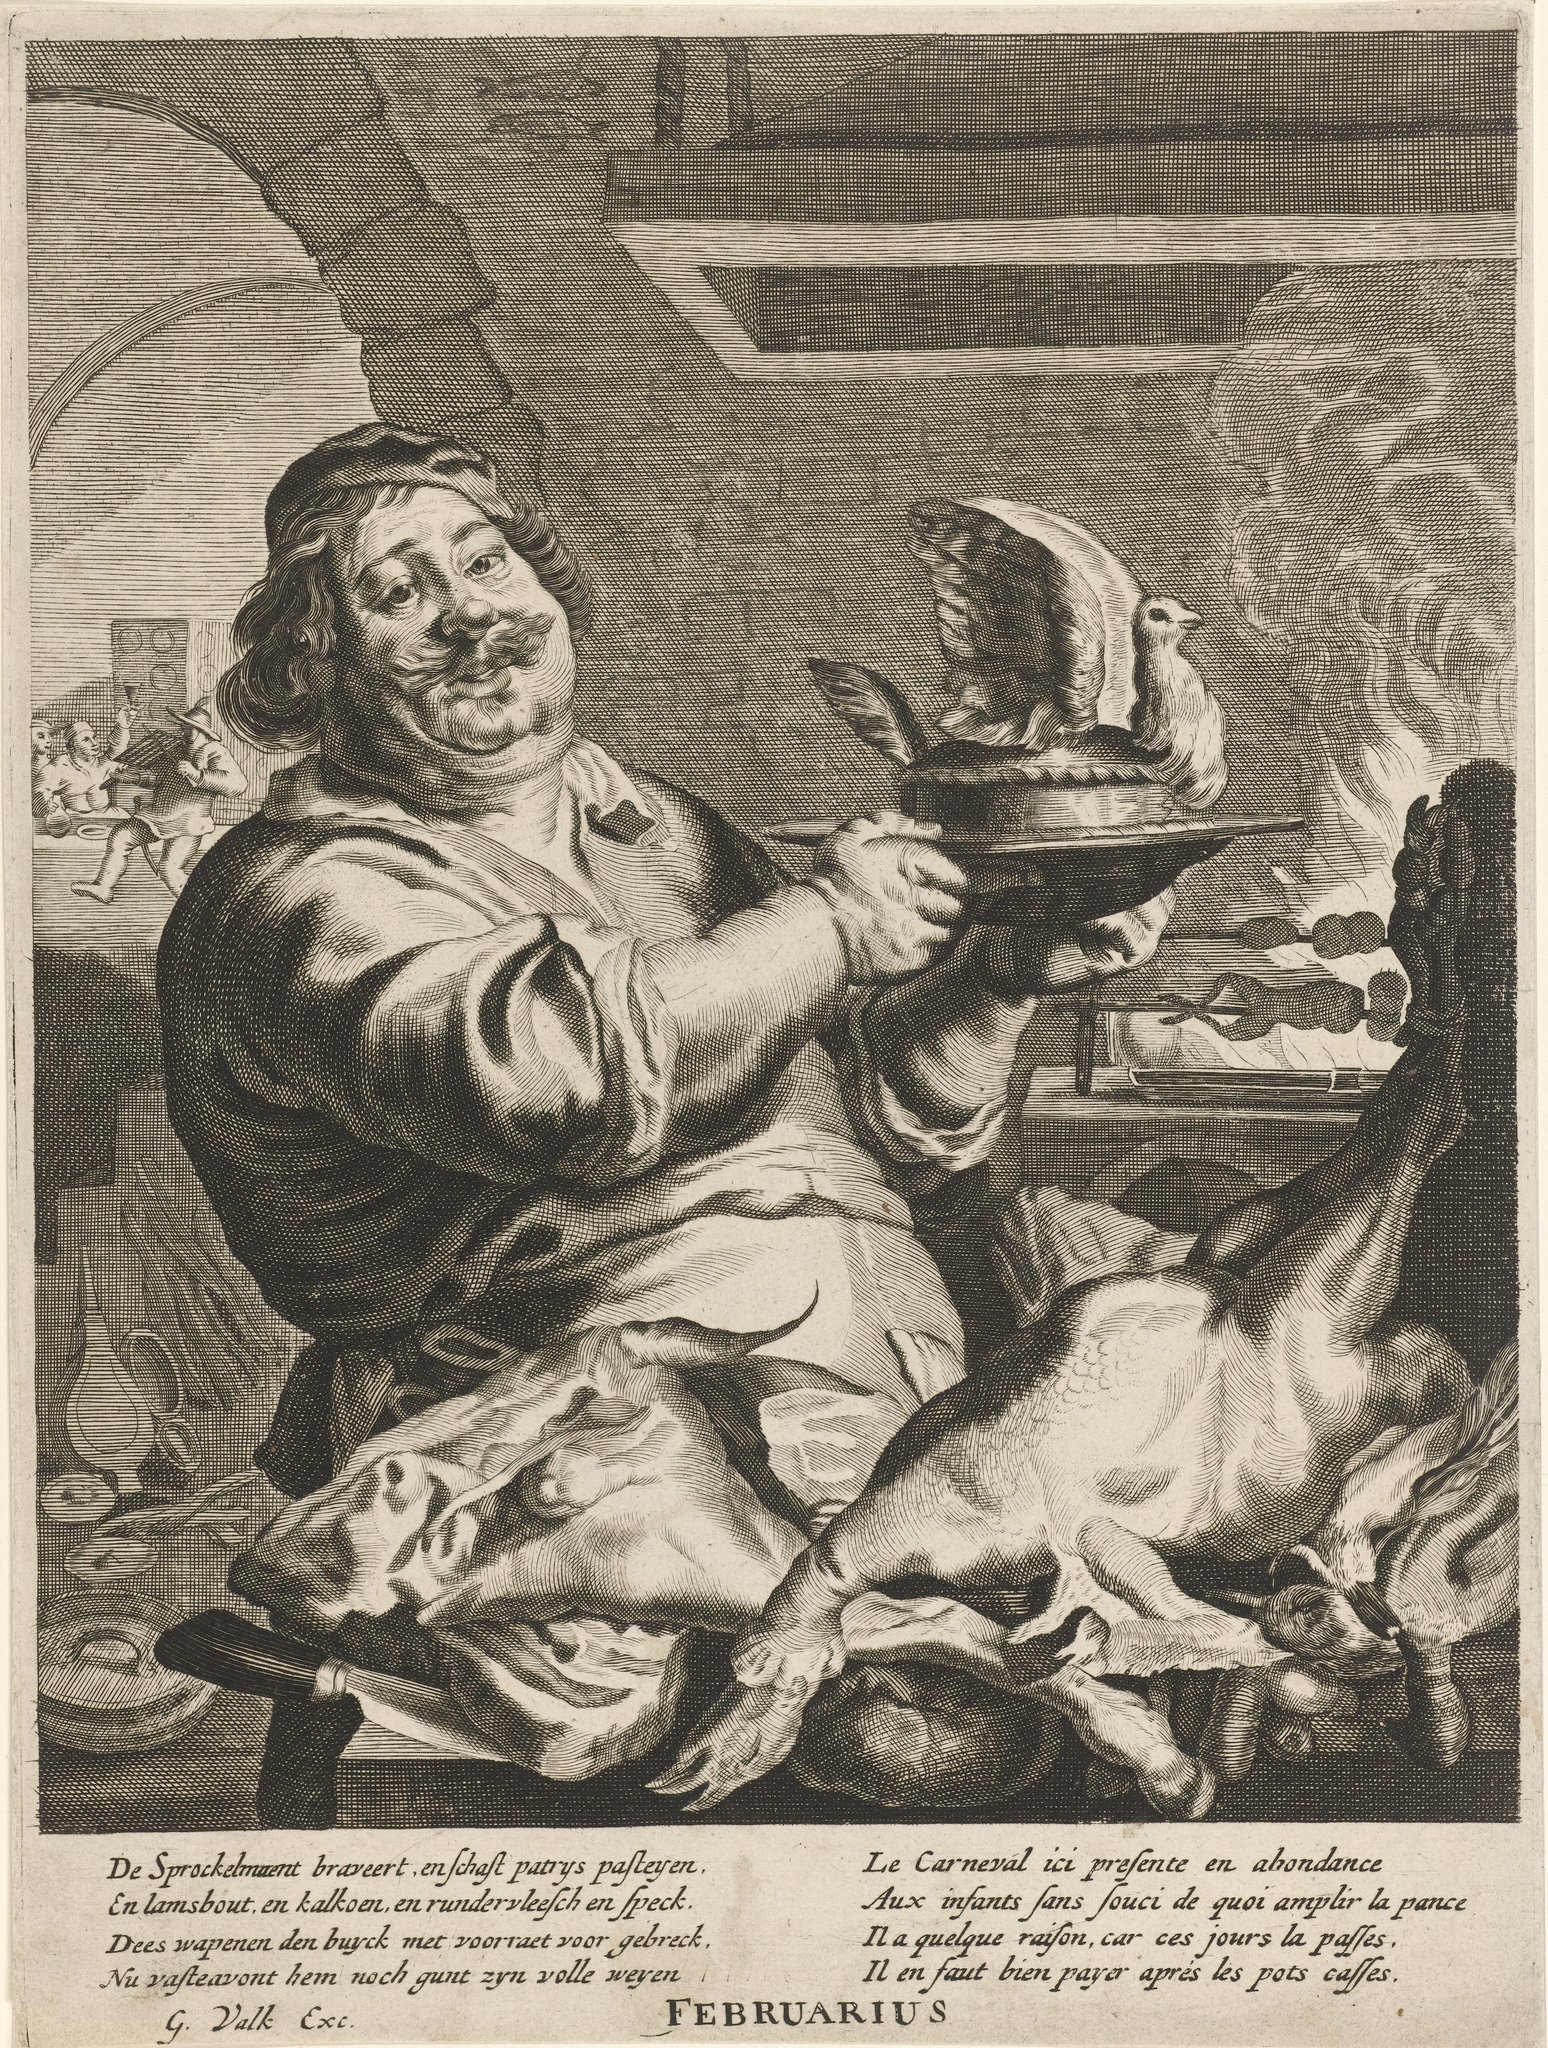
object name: print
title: Februarius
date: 1661-1726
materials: paper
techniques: engraving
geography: amsterdam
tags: february; 'febraro' (ripa), pastry cook, cook, kitchen-interior, improvised musical instruments (kitchen-utensils, etc.), spit ~ cooking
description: Een kok in een keuken met in zijn handen een schaal met een pastei. Op de voorgrond vlees en gevogelte en op de achtergrond een spit. Links op de achtergrond een doorkijk naar drinkende en dansende boeren met een rooster als muziekinstrument.